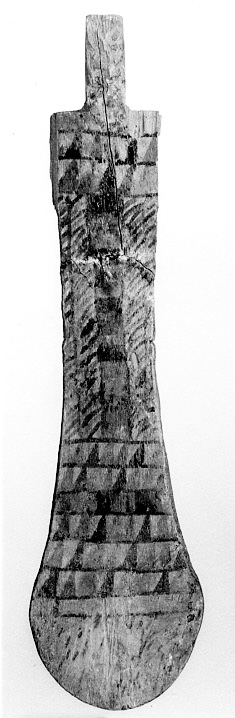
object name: paddle doll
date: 2030-1981 BCE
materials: paint, wood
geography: egypt